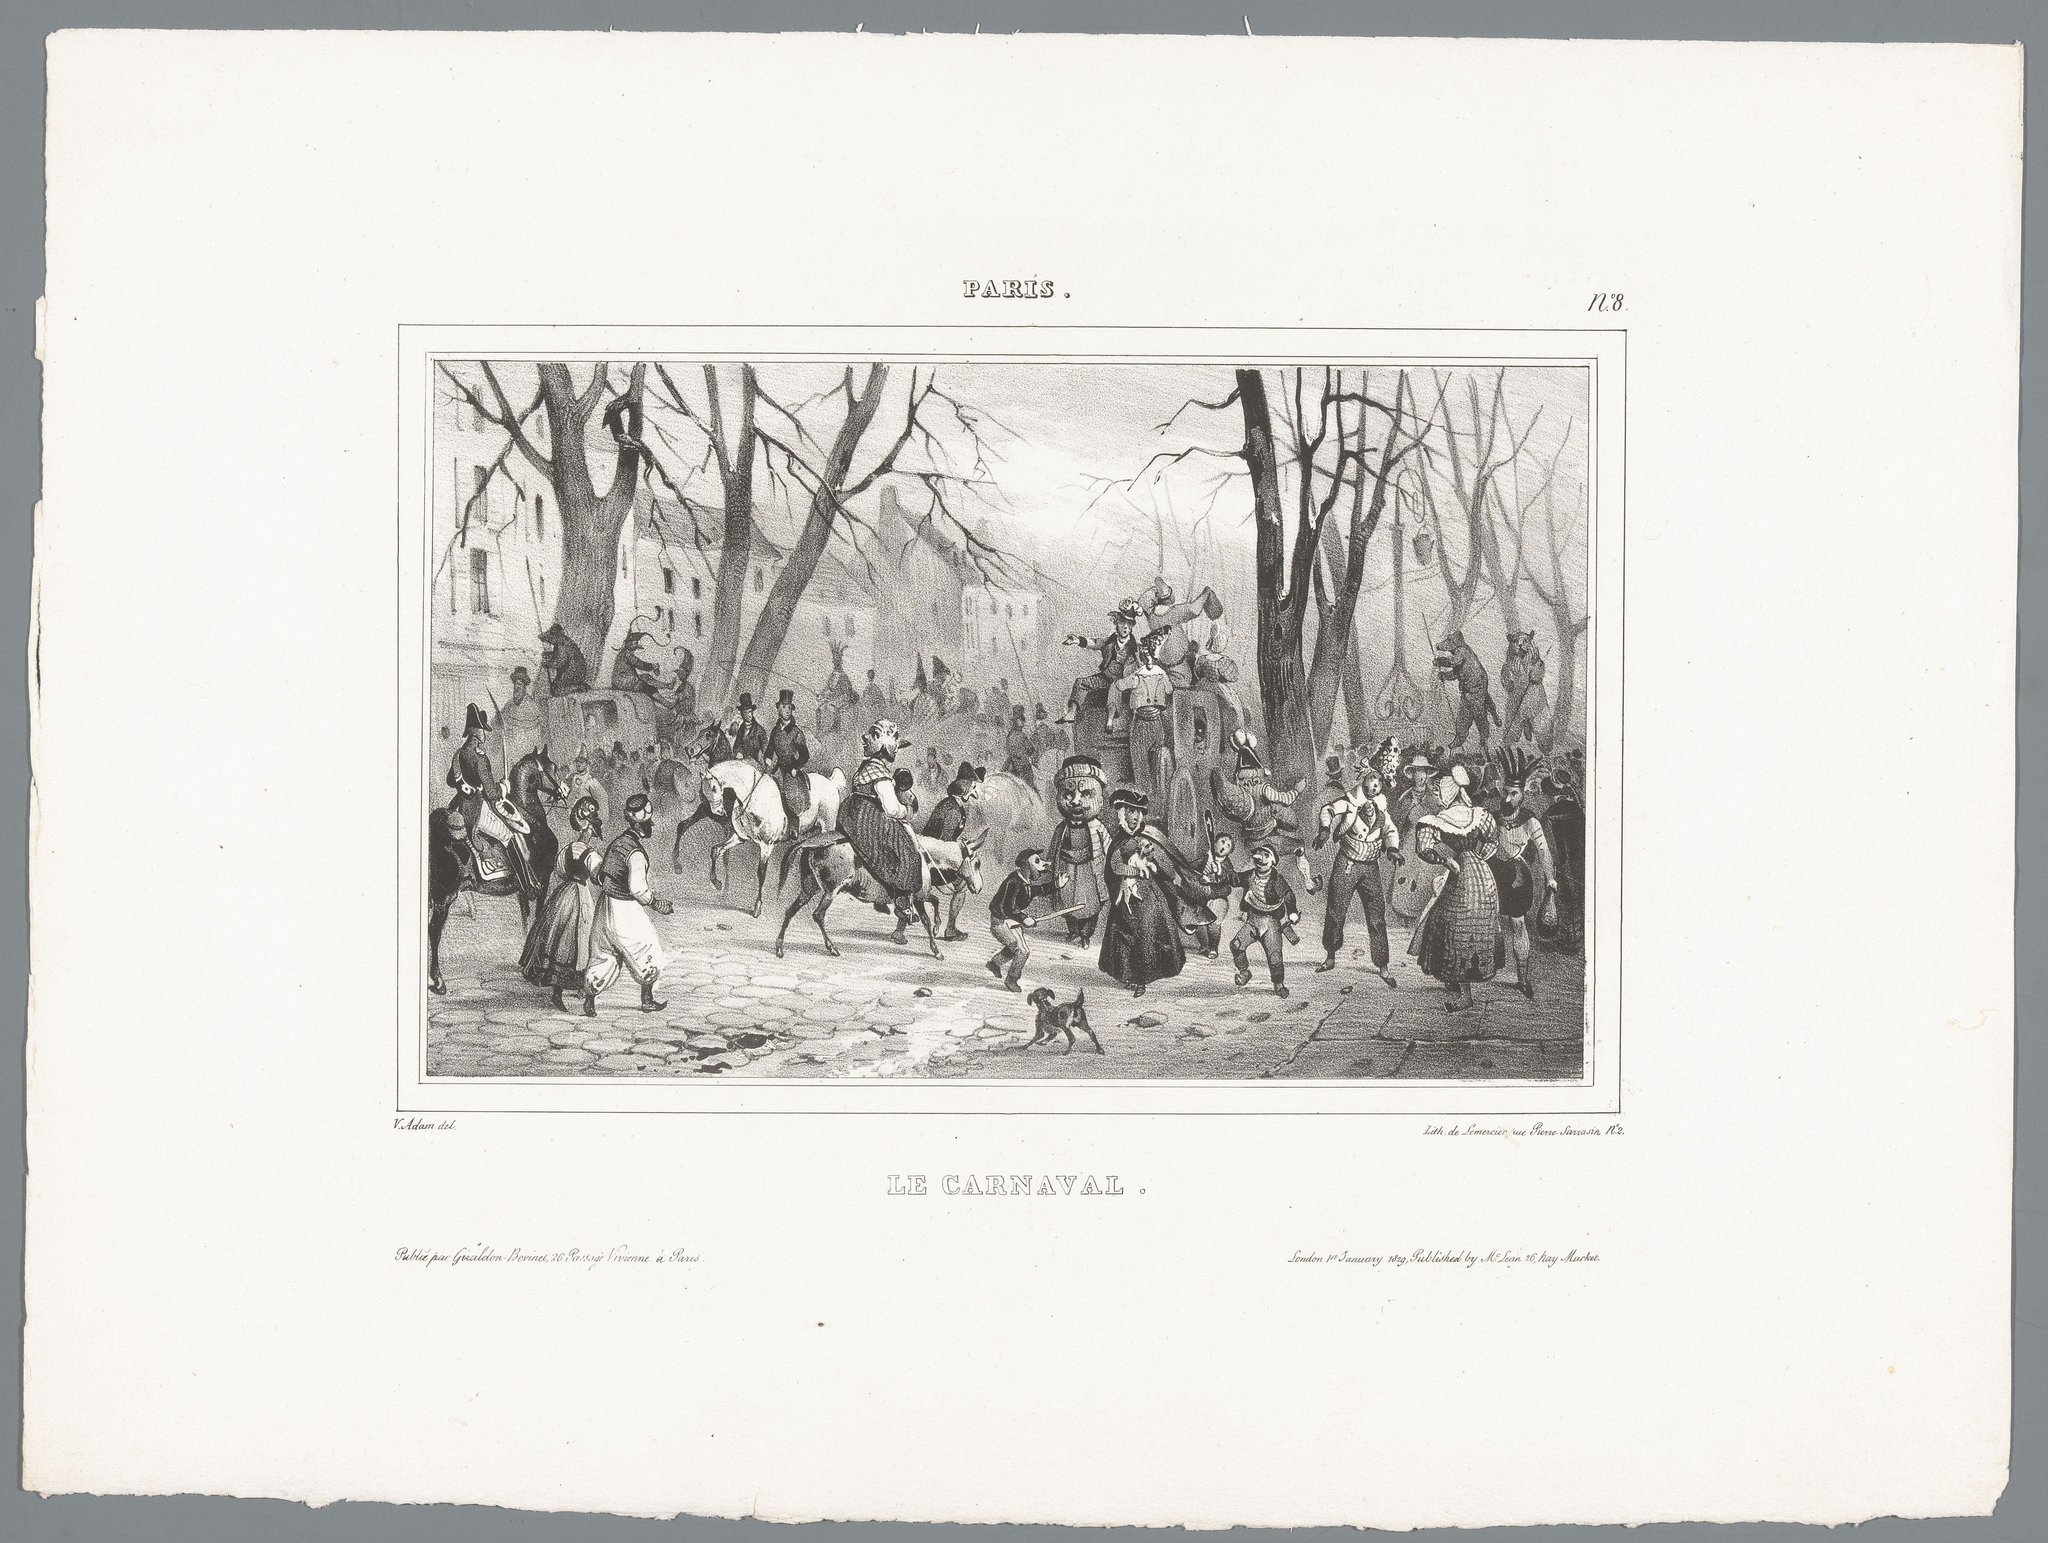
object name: print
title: Carnavalsoptocht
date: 1829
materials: paper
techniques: lithograph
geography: paris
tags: carnival, shrovetide (non-liturgical celebration), shrove tuesday, 'mardi gras' ~ non-liturgical celebrations of carnival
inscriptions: collector's mark: Lugt 2228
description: Een carnavalsoptocht met paarden, wagens, poppen en maskers trekt door een straat in Parijs.